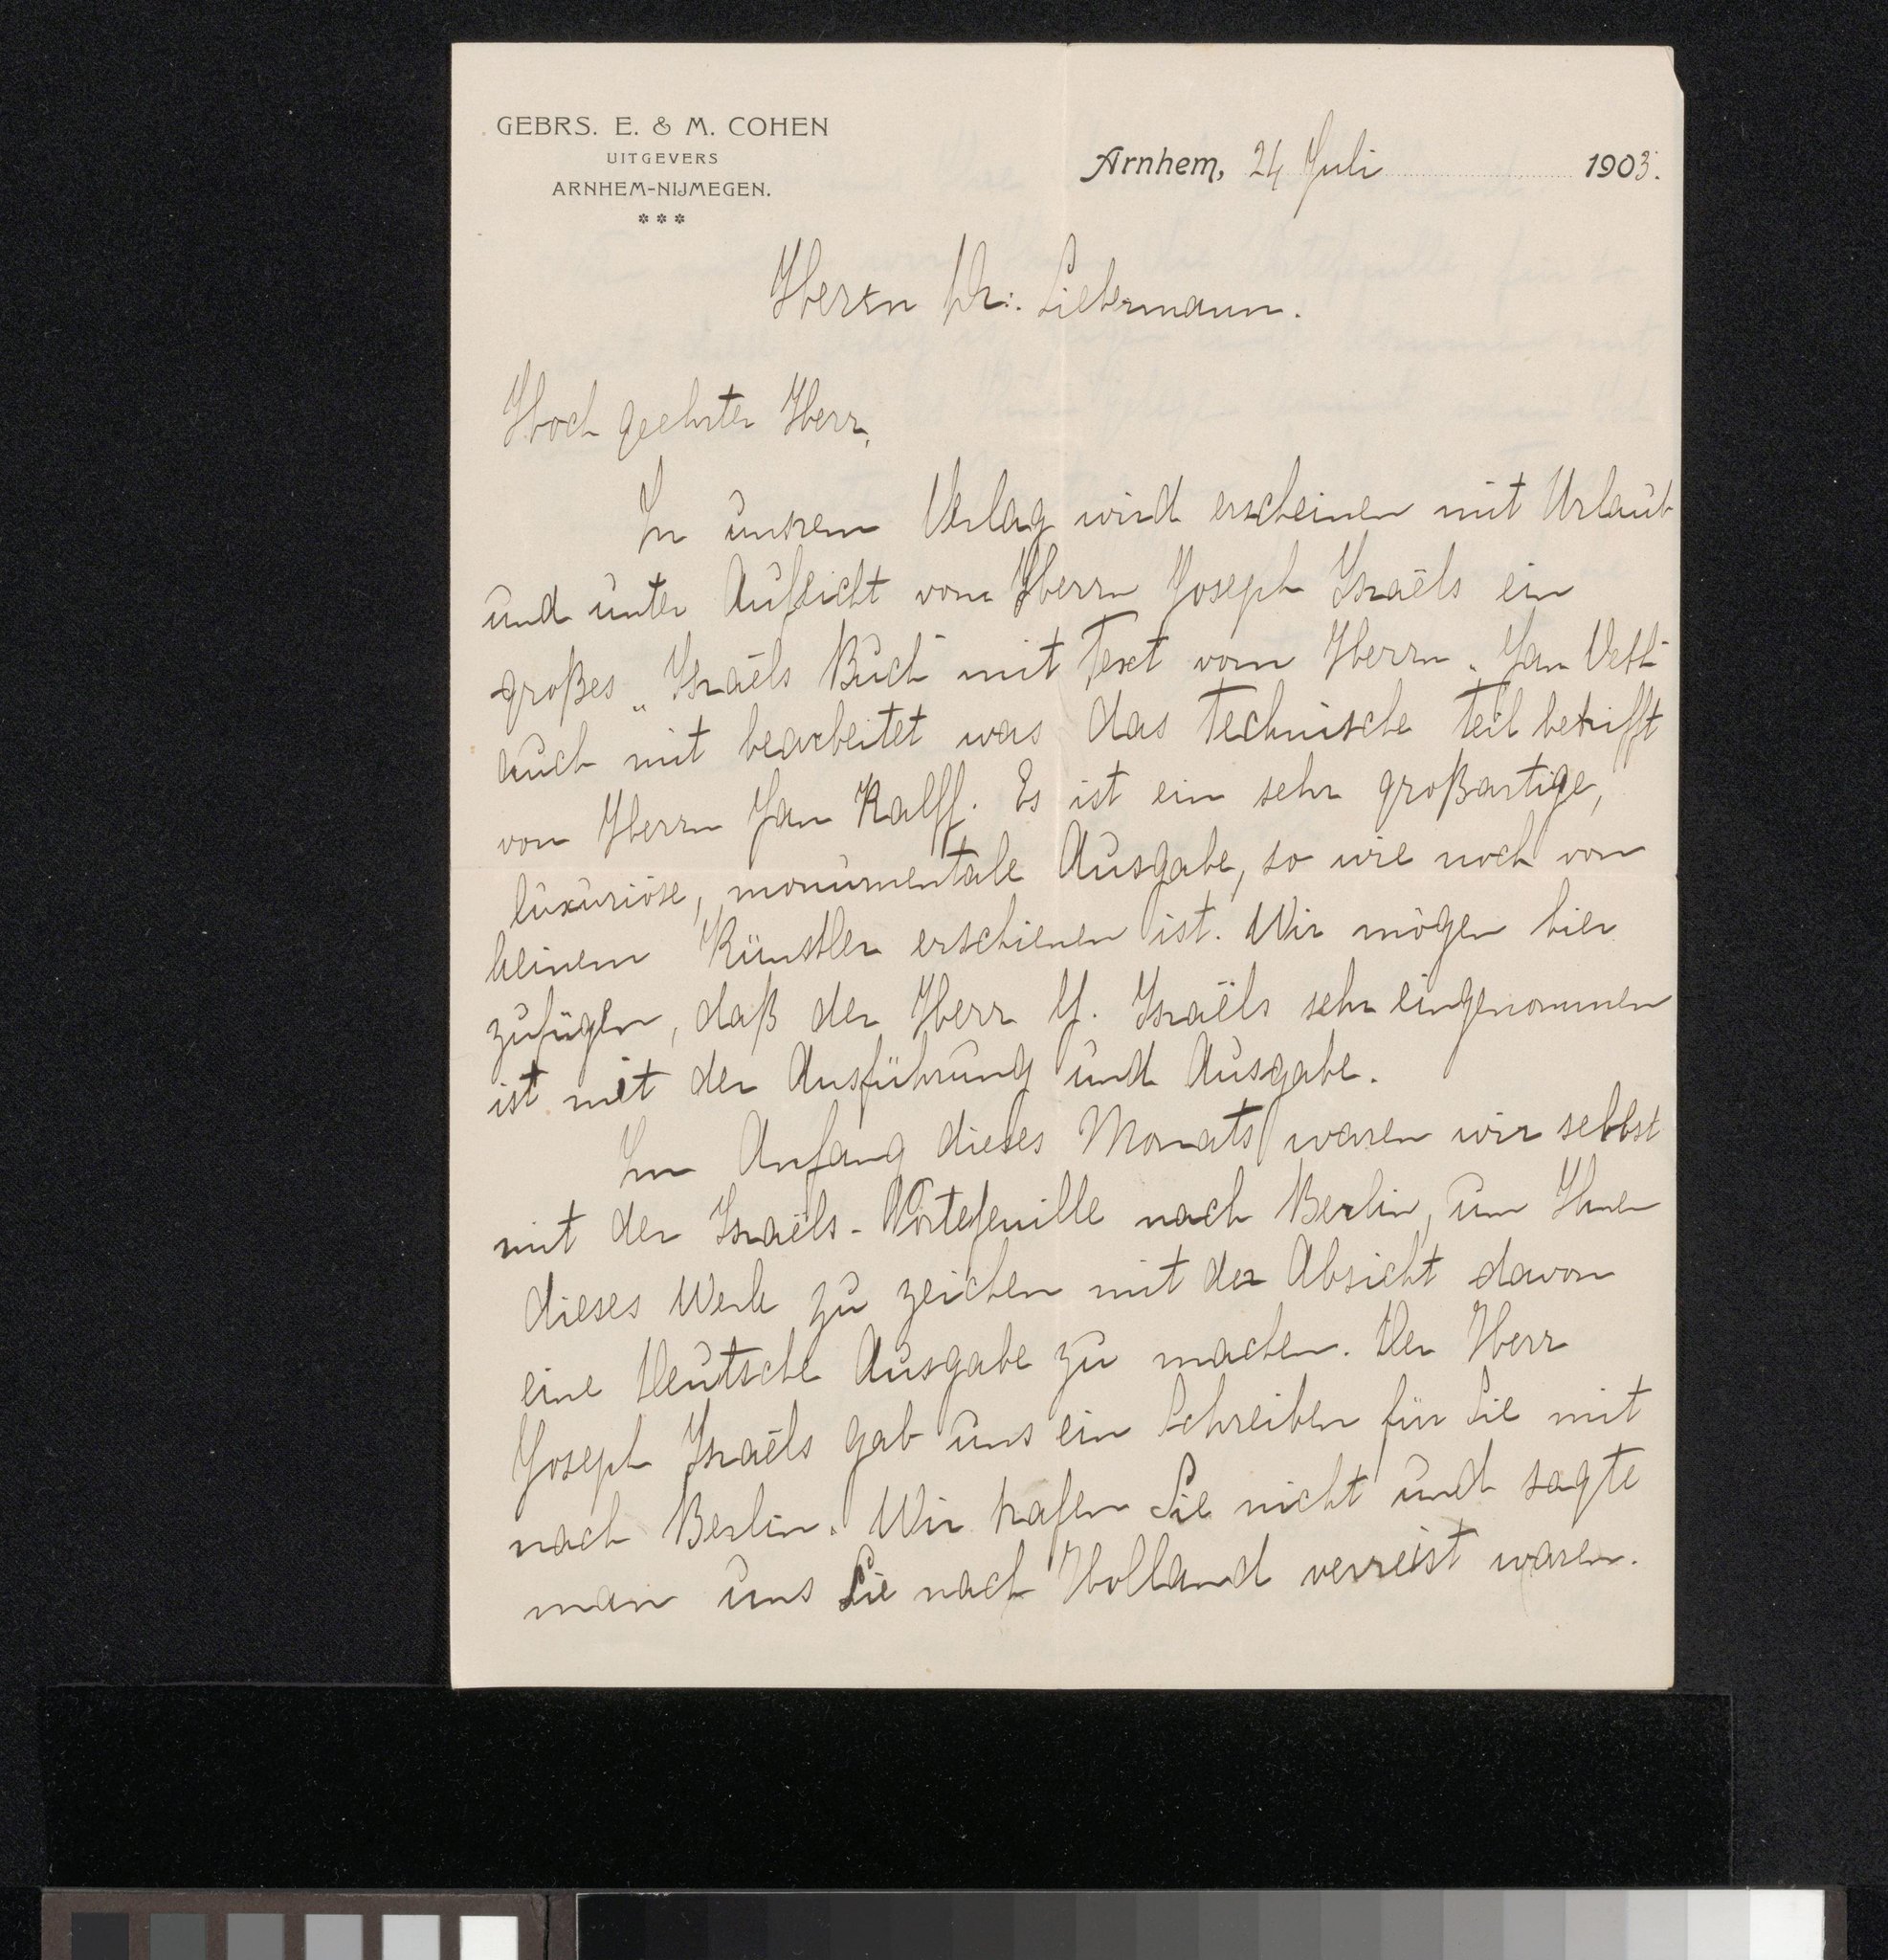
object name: letter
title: Brief aan Max Liebermann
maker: max liebermann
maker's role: draughtsman, print maker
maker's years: 1847-1935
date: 1903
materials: ink, paper, pencil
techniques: pen, printing, writing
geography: arnhem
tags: the hague, painter, jozef israëls, dordrecht, amsterdam, designer, jan veth, bruno cassirer, berlin, print maker, draughtsman, max liebermann, jan kalff, photography, cinematography, historical persons (portraits and scenes from the life), printed matter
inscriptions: collector's mark: ‘RPK’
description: Opgenomen in: Ernst Braun, Max Liebermann: Briefe 1902-1906, Baden-Baden: Deutscher Wissenschafts-Verlag, 2013, Band 3, p. 123-124.